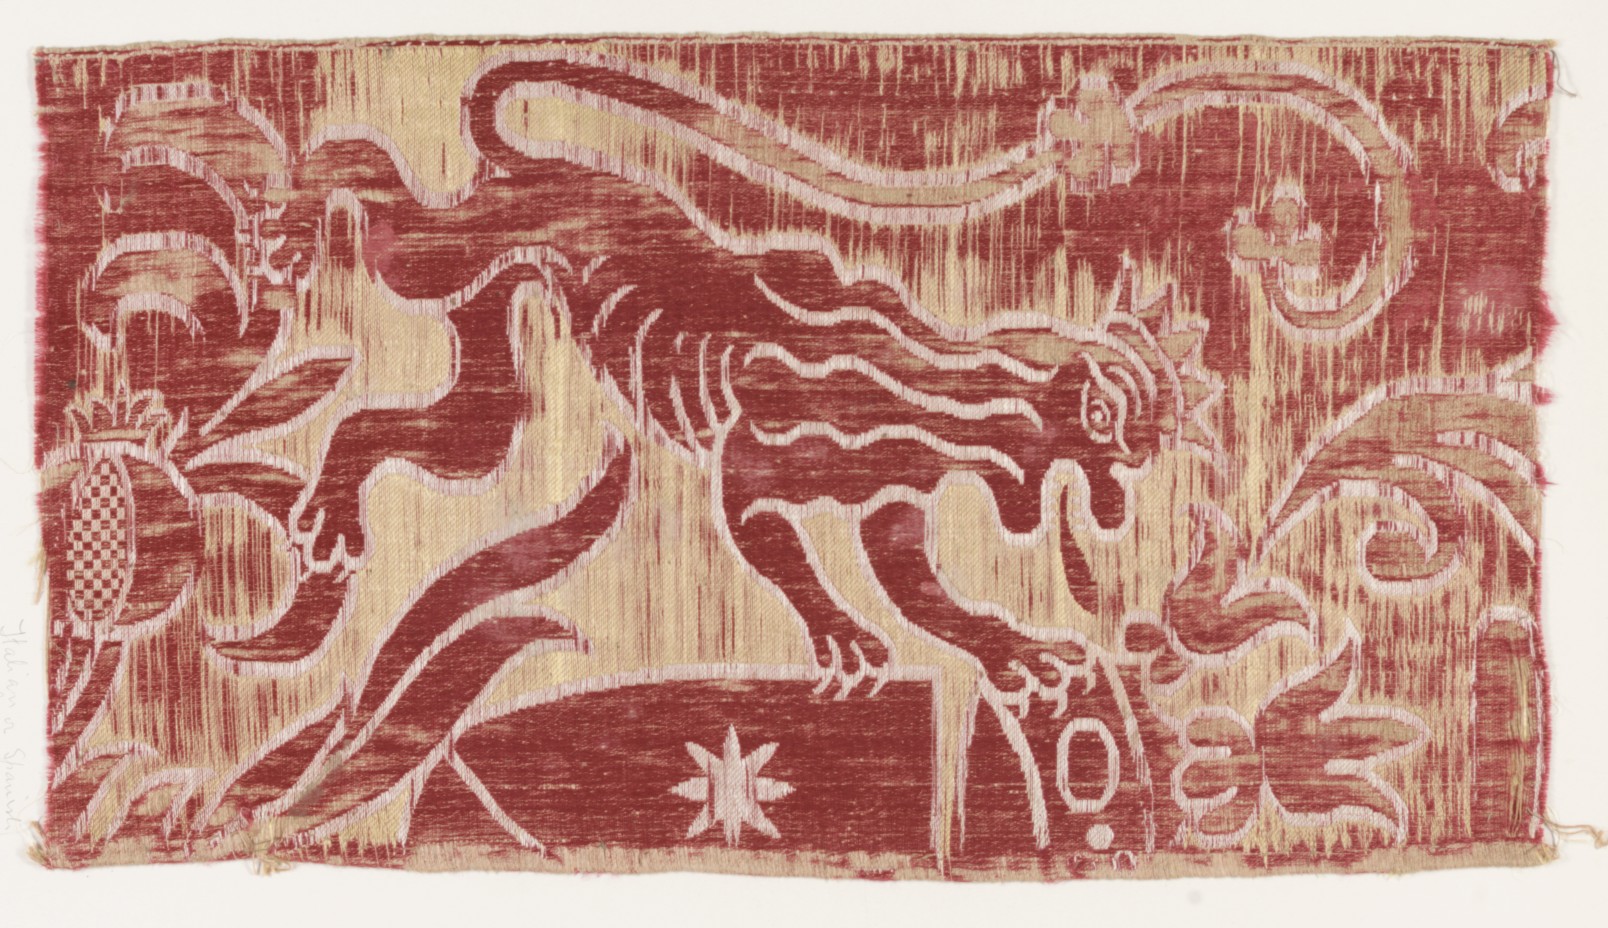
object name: fragment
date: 1501-1700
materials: silk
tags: lions